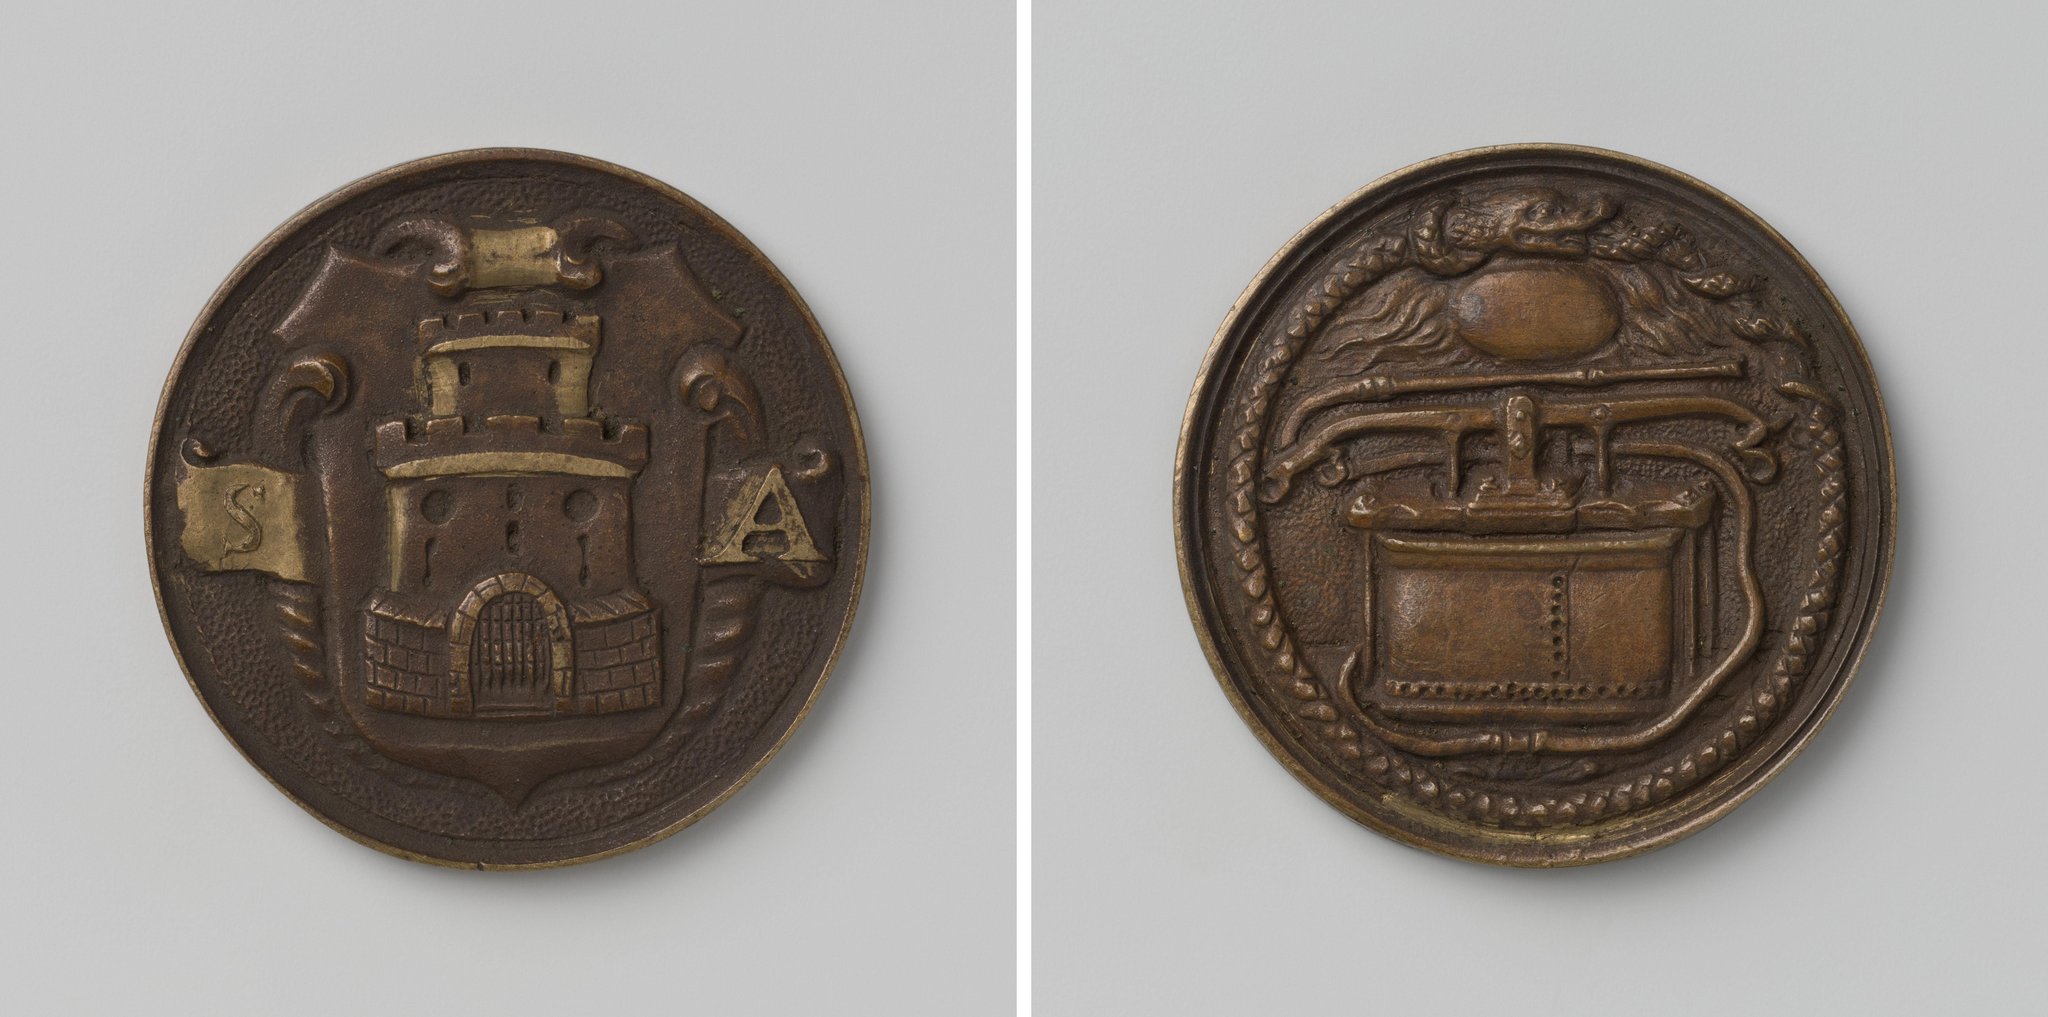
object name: fire engine medal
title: Onbekende plaats, brandspuitpenning van spuit A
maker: Anonymous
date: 1680-1800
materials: brass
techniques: casting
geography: netherlands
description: Messing penning. Voorzijde: wapenschild met burch in cartouche voor lint met opschrift S.A.. Keerzijde: brandspuit onder leeg cartouche binnen slangerond